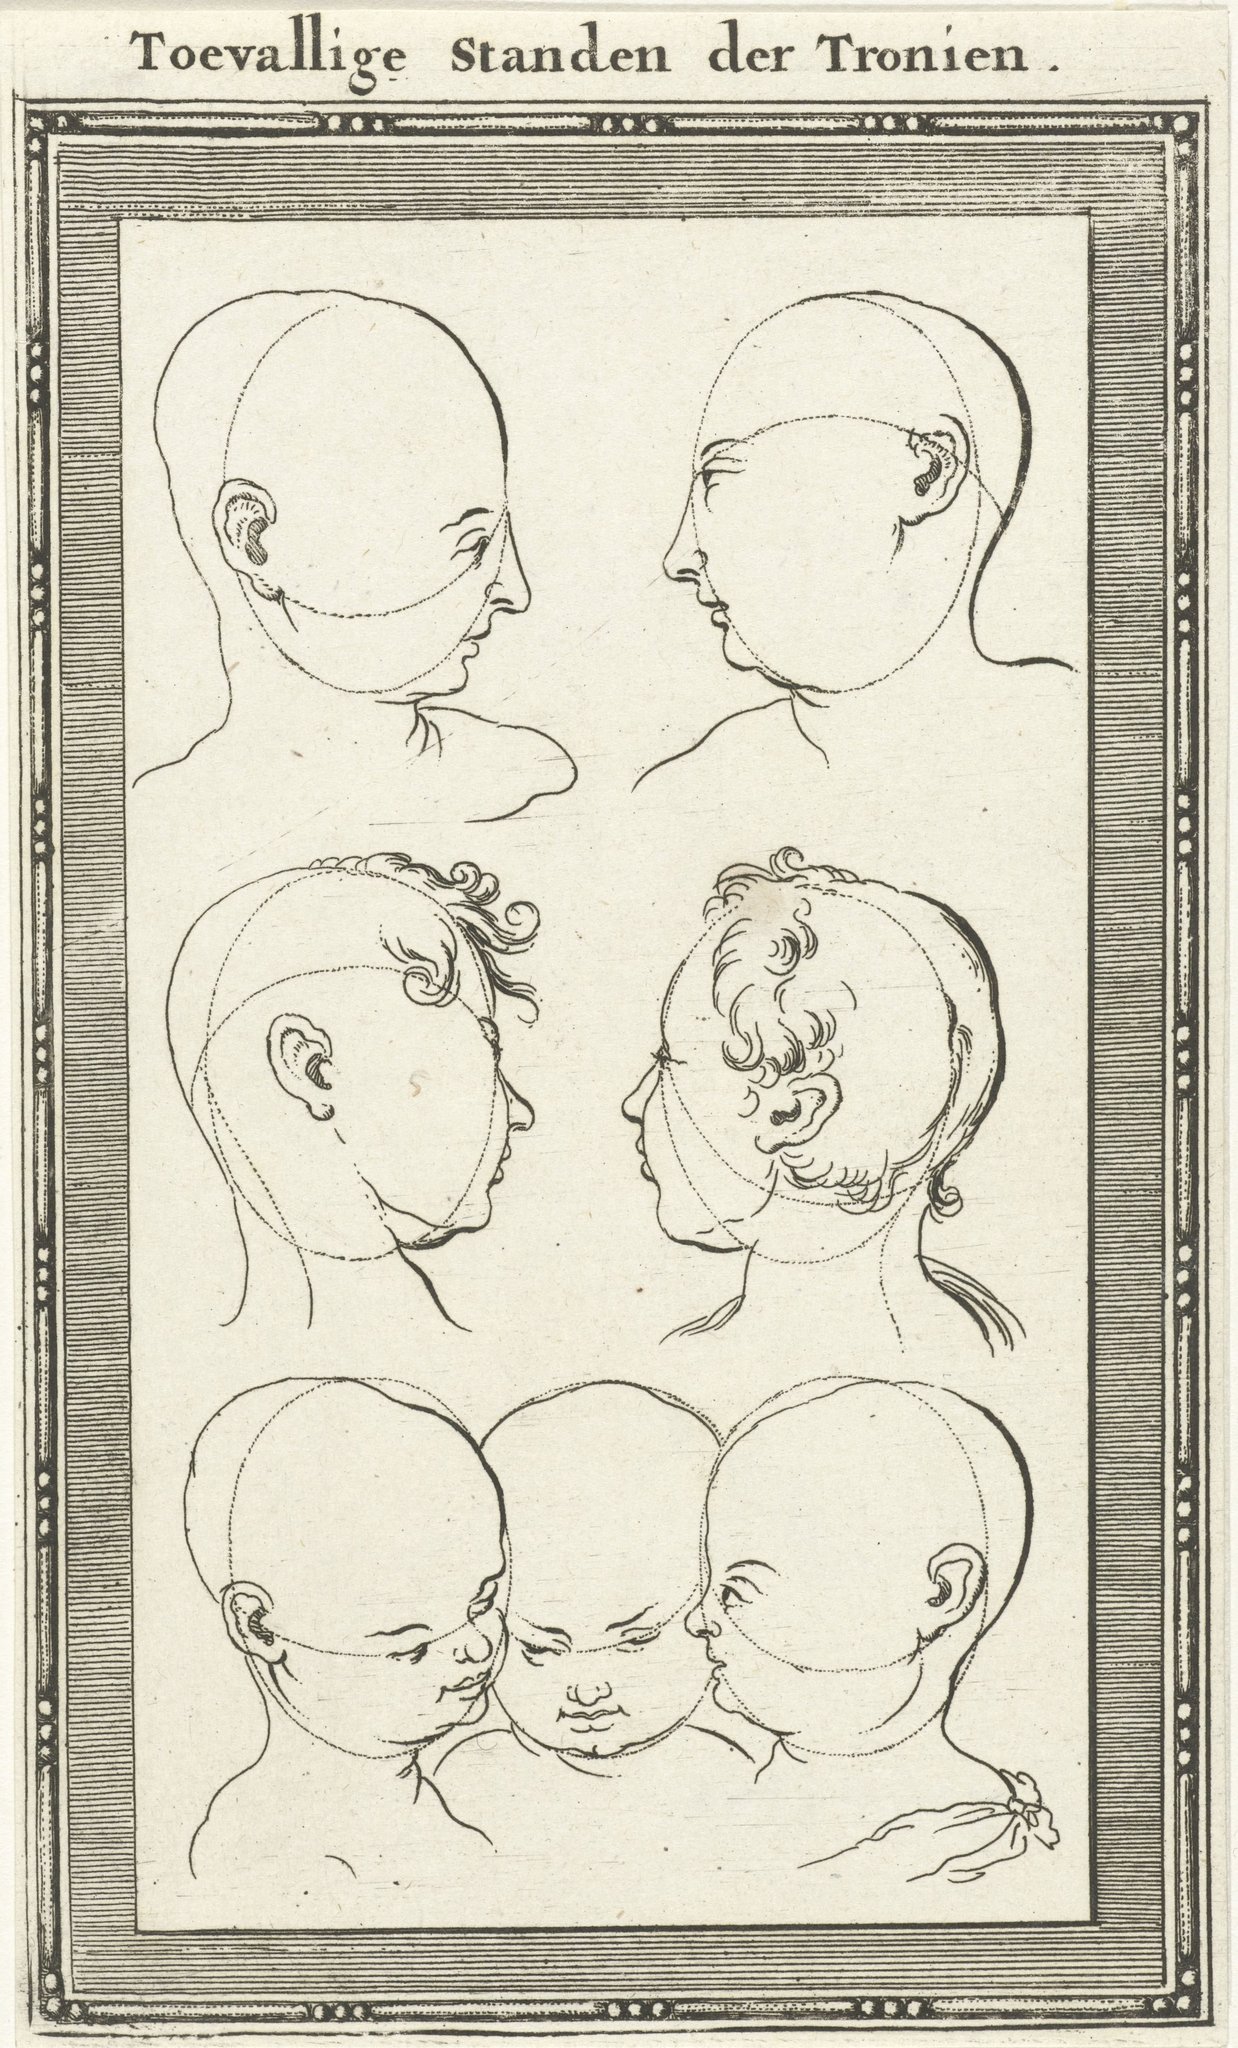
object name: book illustration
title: Toevallige Standen der Tronien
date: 1682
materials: paper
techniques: etching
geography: amsterdam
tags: head (human)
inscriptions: collector's mark: Lugt 2228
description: Illustratie opgenomen in: Goeree, Wilhelmus. Natuurlyk en schilderkonstig ontwerp der menschkunde, p. 234. Amsterdam: Wilhelmus Goeree (I), 1682.